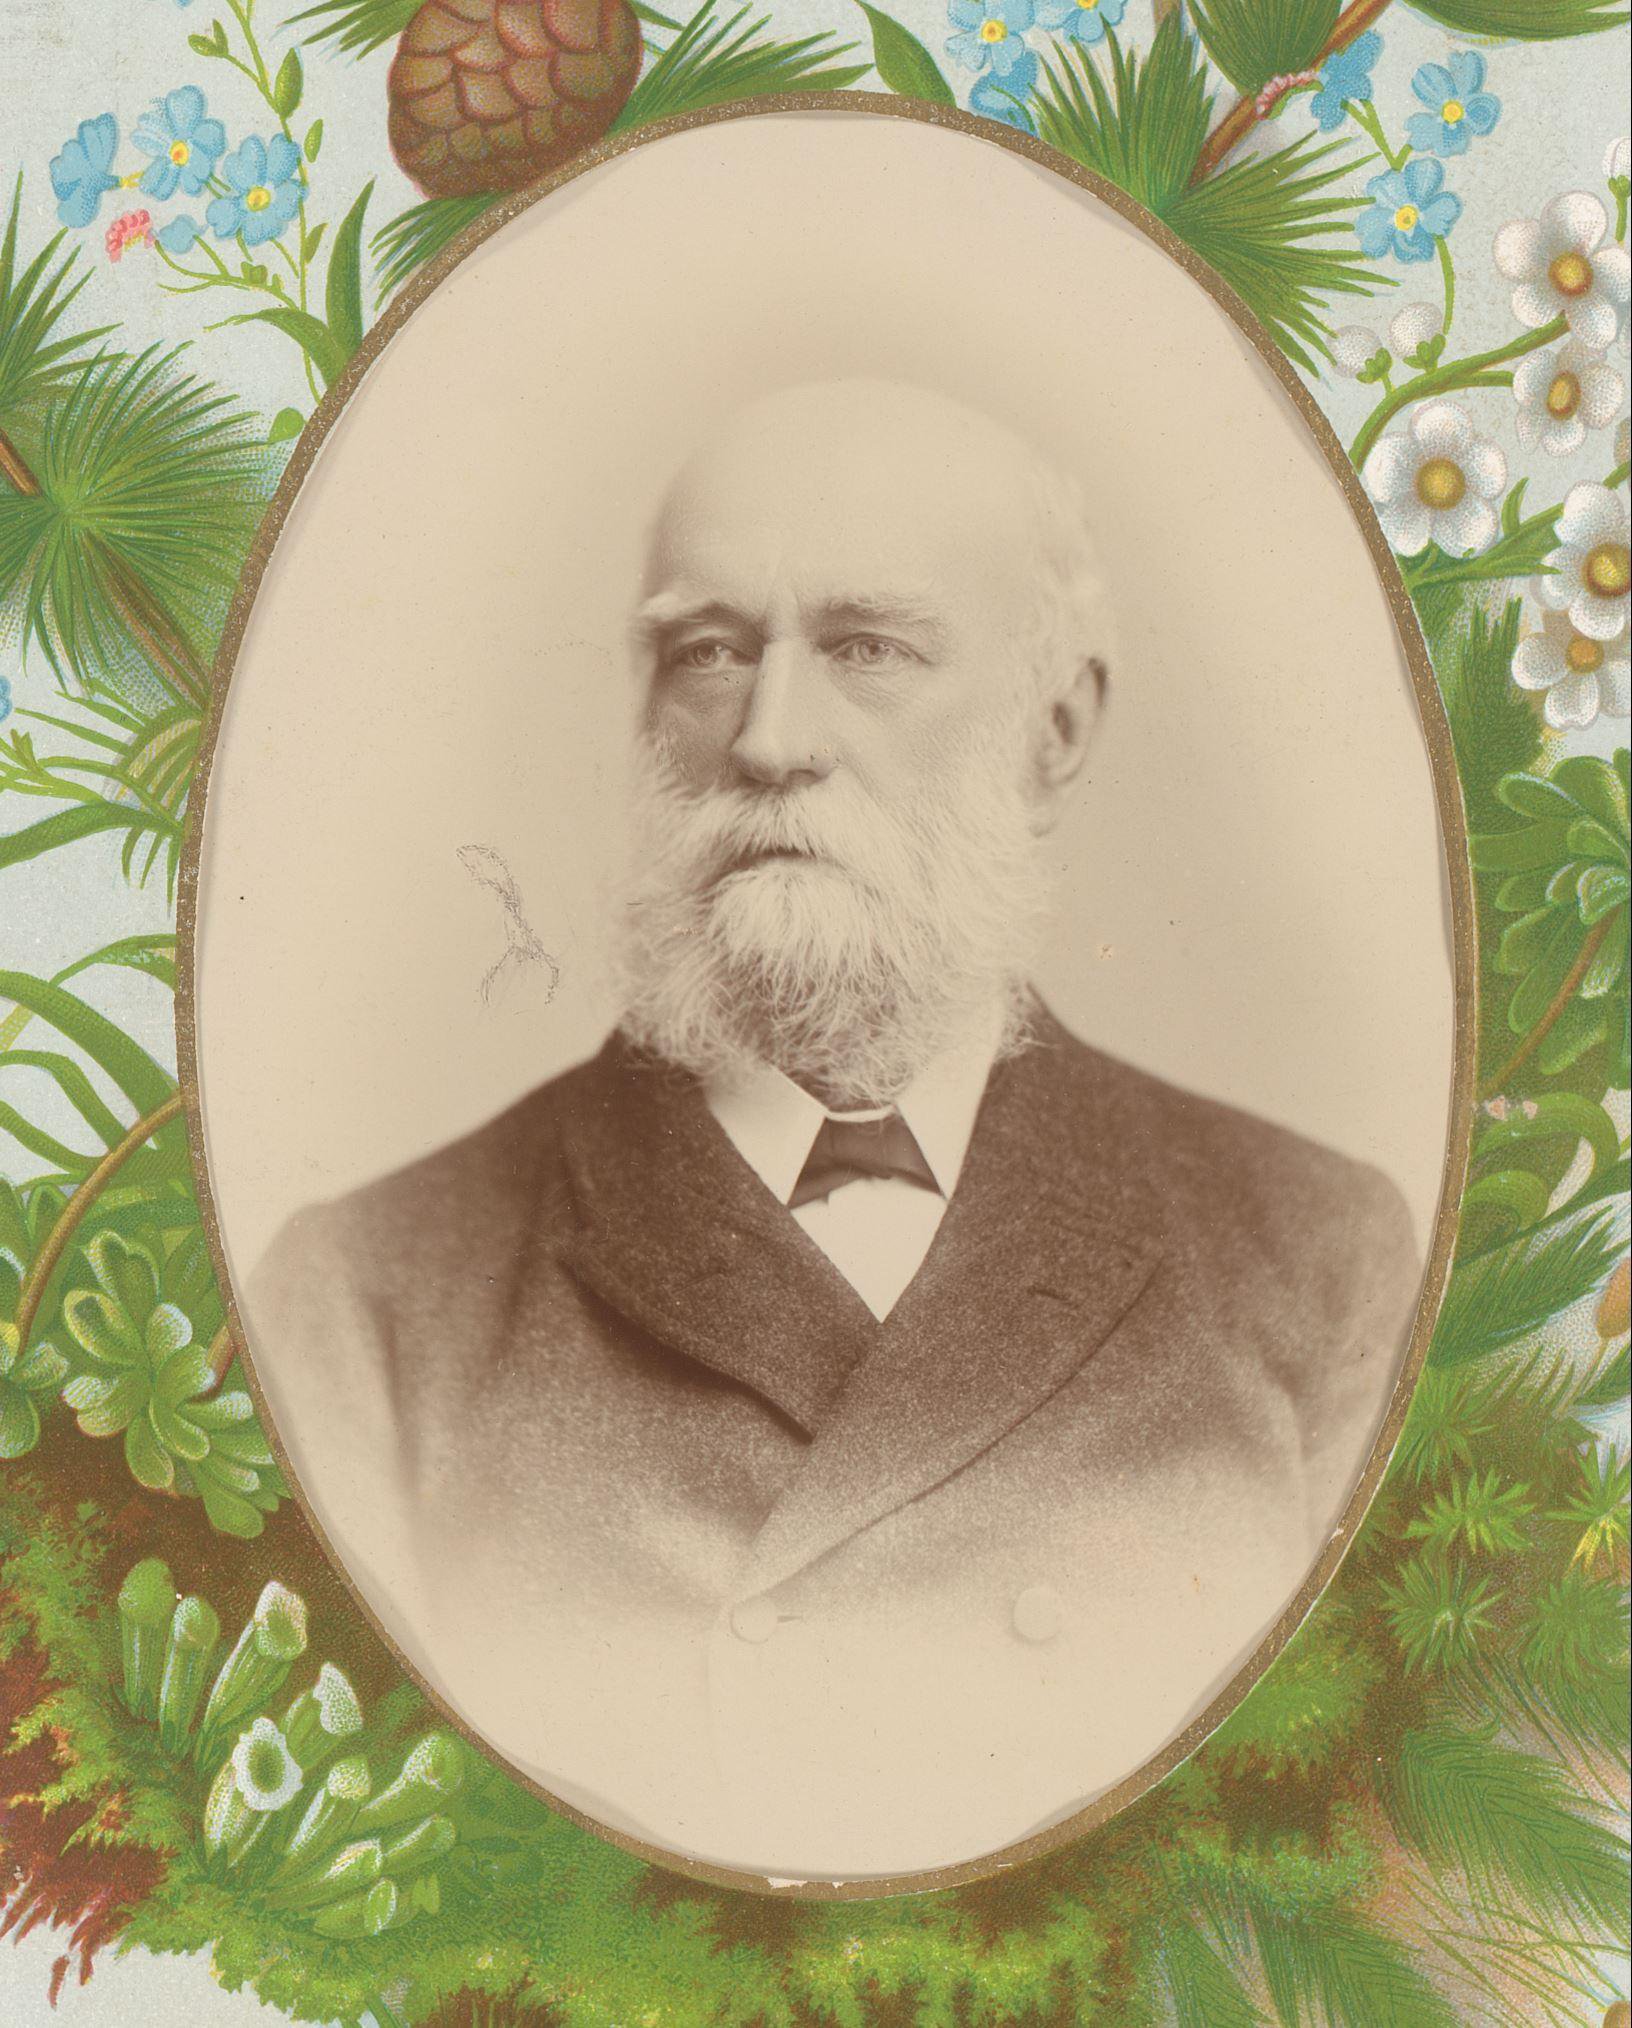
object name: album leaf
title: Portret van een man met baard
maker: william edward bartier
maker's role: fotograaf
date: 1867-1890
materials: cardboard, paper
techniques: albumen print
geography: london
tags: moustache, adult man, historical persons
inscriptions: inscription: ‘FROM THE/ PHOTOGRAPHIC/ STUDIO/ OF/ W. Bartier/ 134/ EAST INDIA ROAD/ Poplar,/ E./ COPIES OF THIS PHOTOGRAPH/ CAN ALWAYS BE OBTAINED/ UPON APPLICATION./ W. Herrmann & Co. Berlin.’, address: ‘134. EAST INDIA RD/ POPLAR. E.’